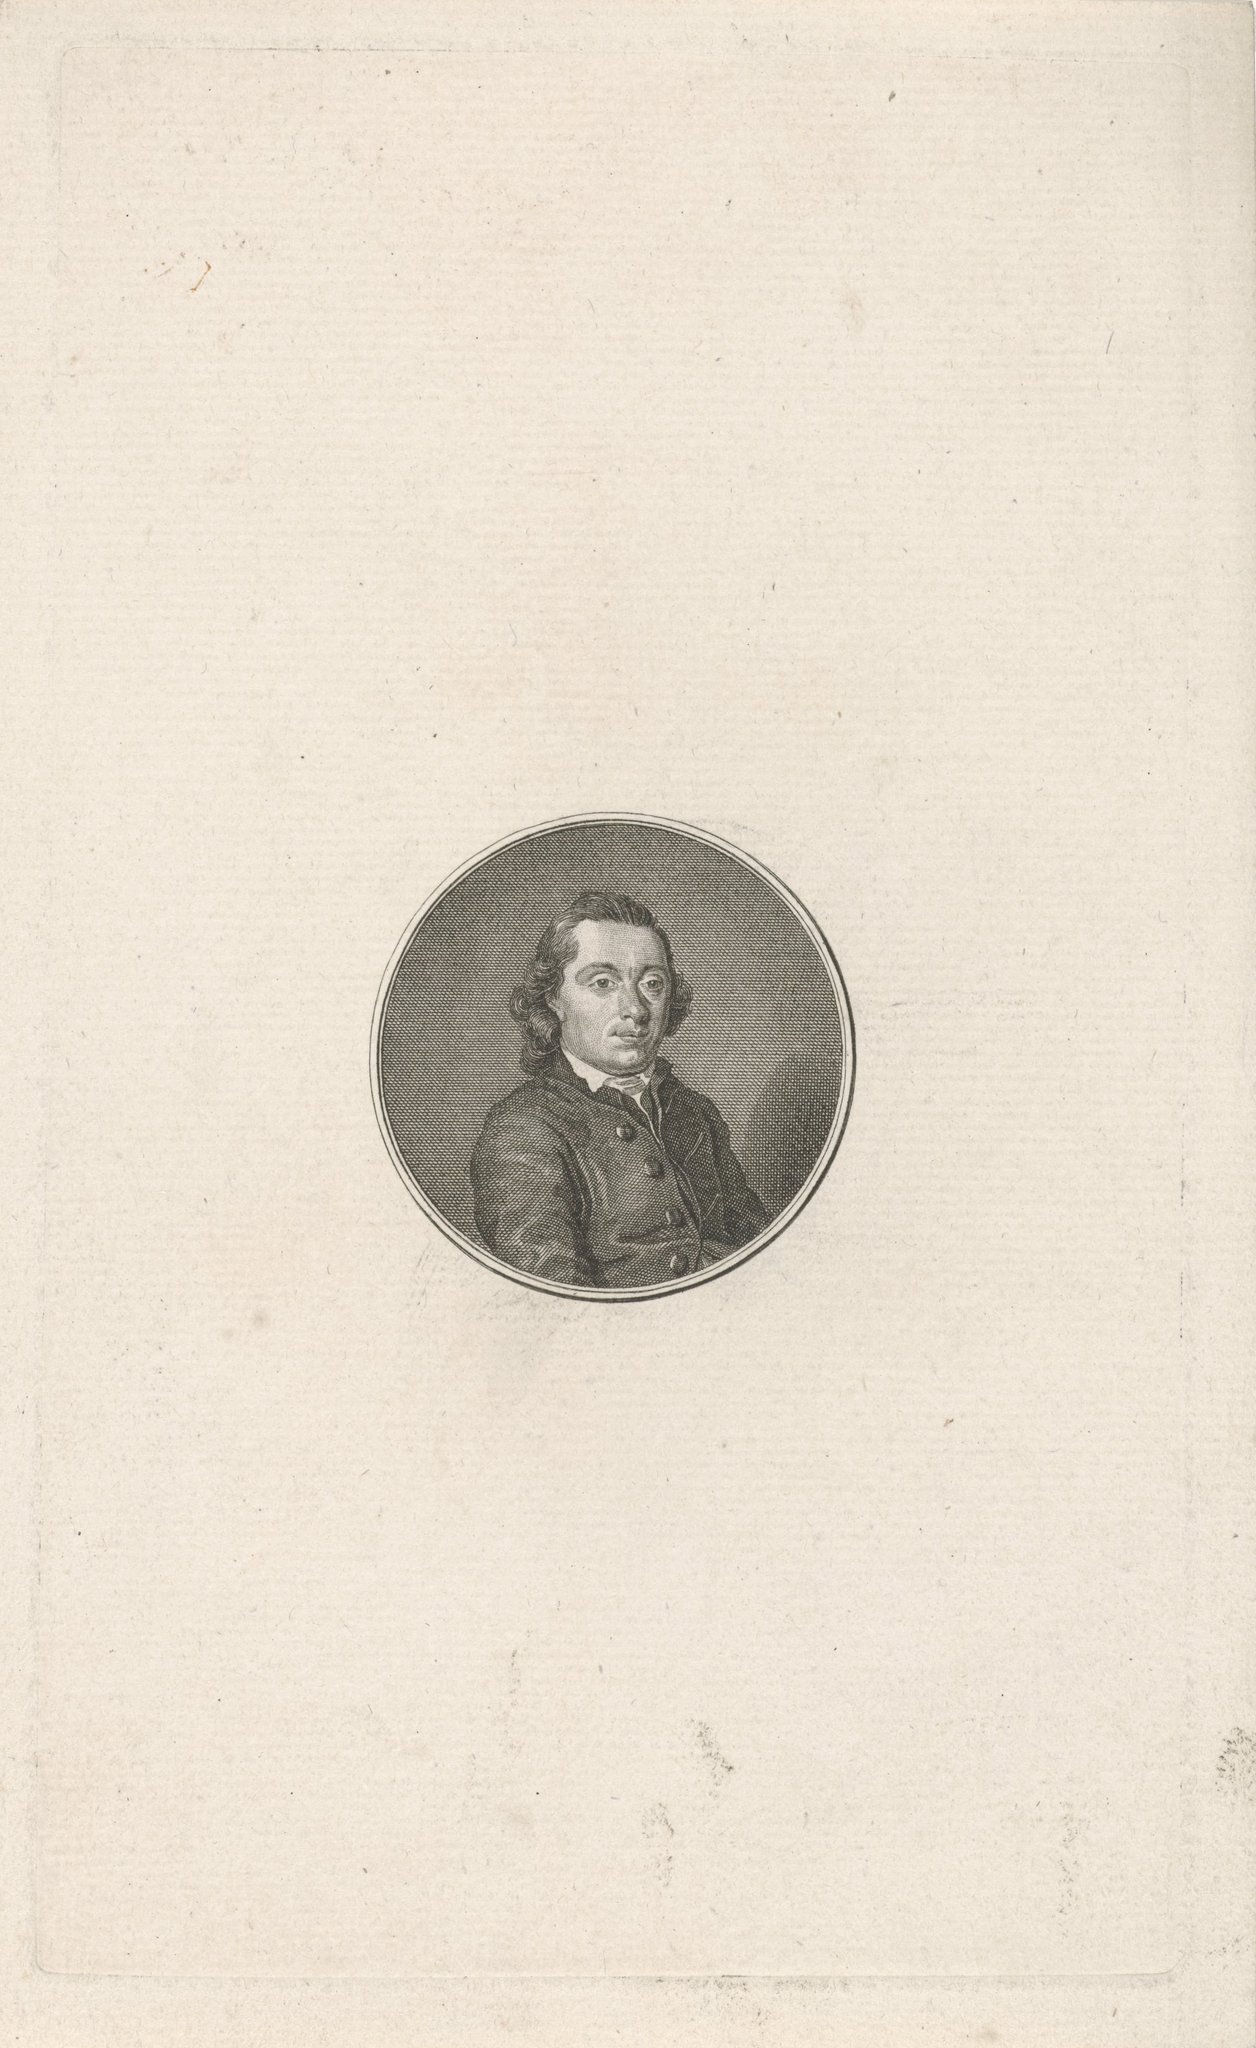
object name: print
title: Portret van Bernardus Bosch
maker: noach van der meer (ii)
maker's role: draughtsman, print maker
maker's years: 1741-1822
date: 1790-1792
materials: paper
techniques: etching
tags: deventer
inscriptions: collector's mark: Lugt 2228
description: Prent mogelijk gebruikt in een van de edities van: Bosch, Bernardus. De leerzame praat-al. 3 dln. Amsterdam: Wijnand Wijnands en Hendrik Brongers junior, 1790-1792.